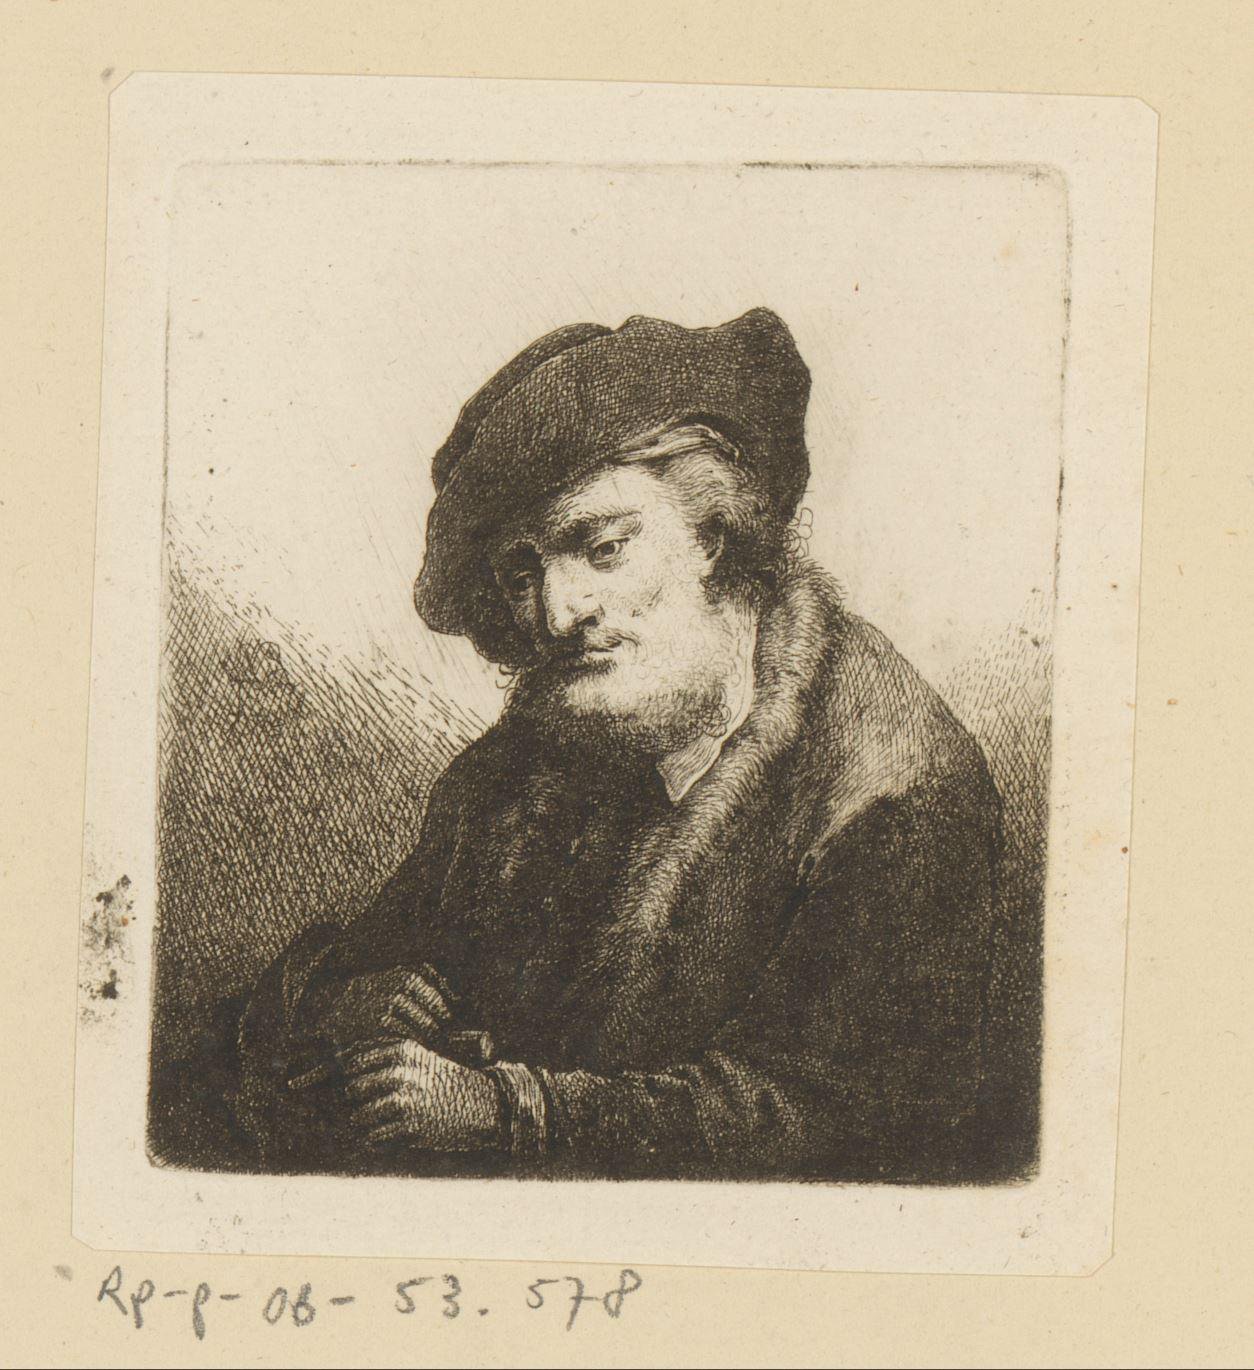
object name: print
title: Man met schuine baret leunend op een stok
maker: johann andreas benjamin nothnagel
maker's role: print maker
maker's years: 1729-1804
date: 1773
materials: paper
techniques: etching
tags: old man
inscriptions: collector's mark: Lugt 240